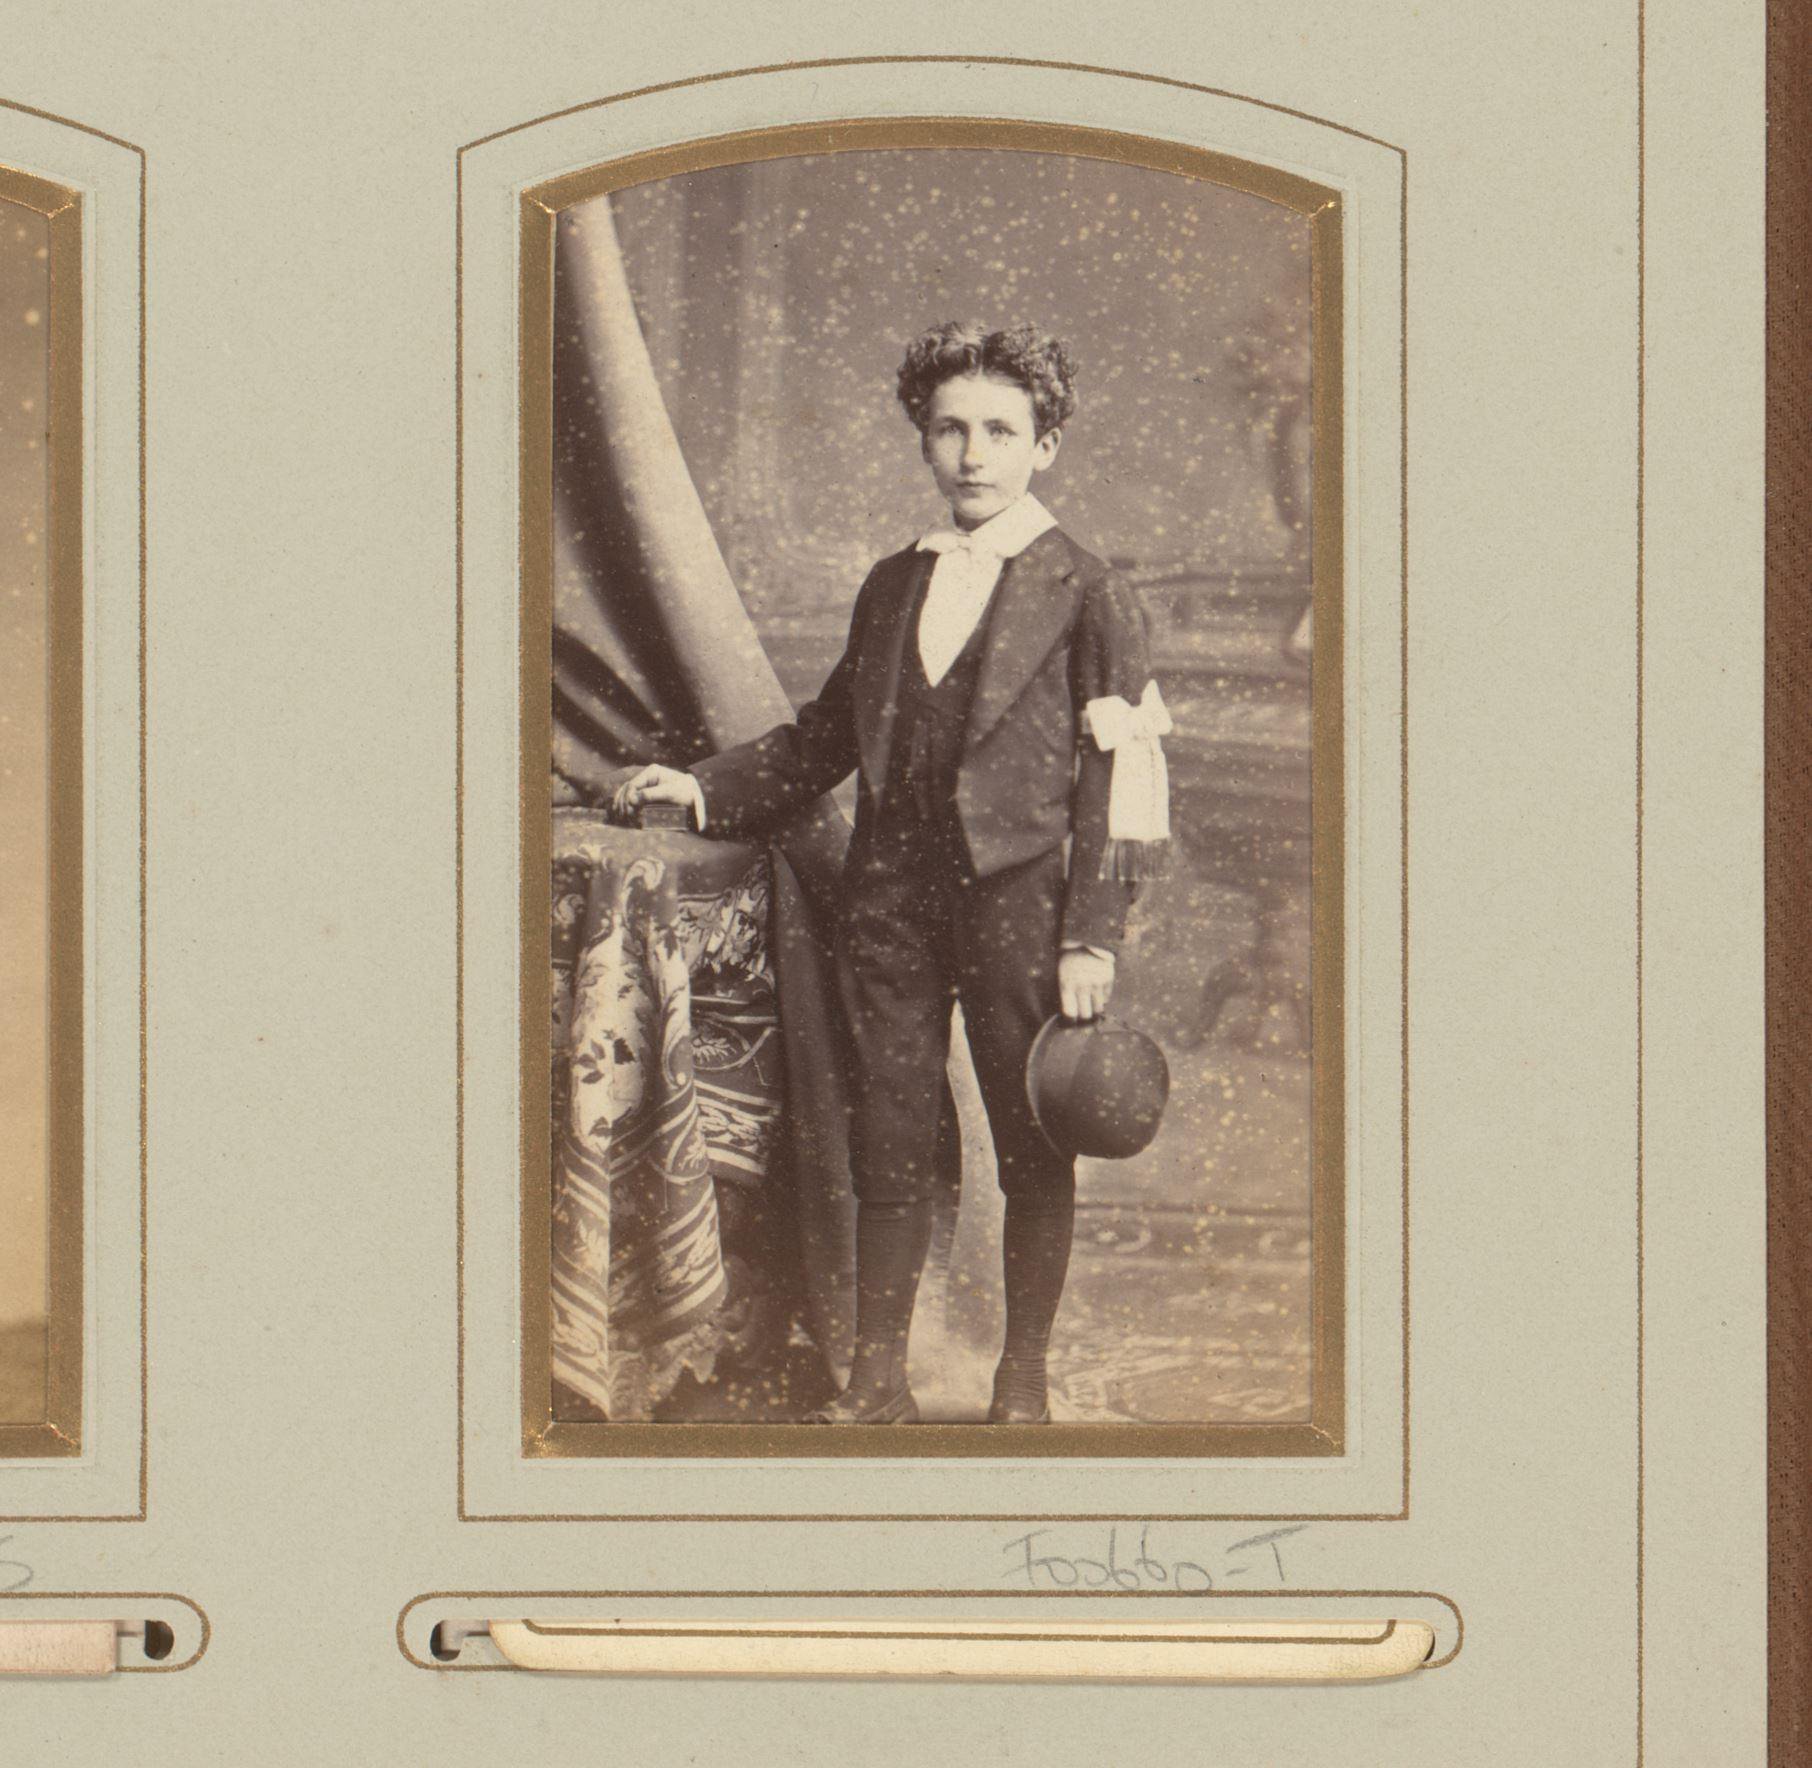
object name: carte de visite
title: Portret van een jongen met hoed in de hand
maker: f. meeus-verbeke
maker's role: fotograaf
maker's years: 1845-1906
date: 1876-1906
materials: cardboard, photographic support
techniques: albumen print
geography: leuven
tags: boy (child between toddler and youth), historical persons, head-gear: hat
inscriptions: inscription: ‘PHOTOGRAPHIE INALTÉRABLE/ Procedé au Charbon/ Meeus Verbeke/ 24. Rue de la Station, 24./ LOUVAIN/ Atelier de Pose au Premier./ Le cliché étant conserve, il suffit de/ rappeler le nom pour obtenir de mêmes/ Cartes.’